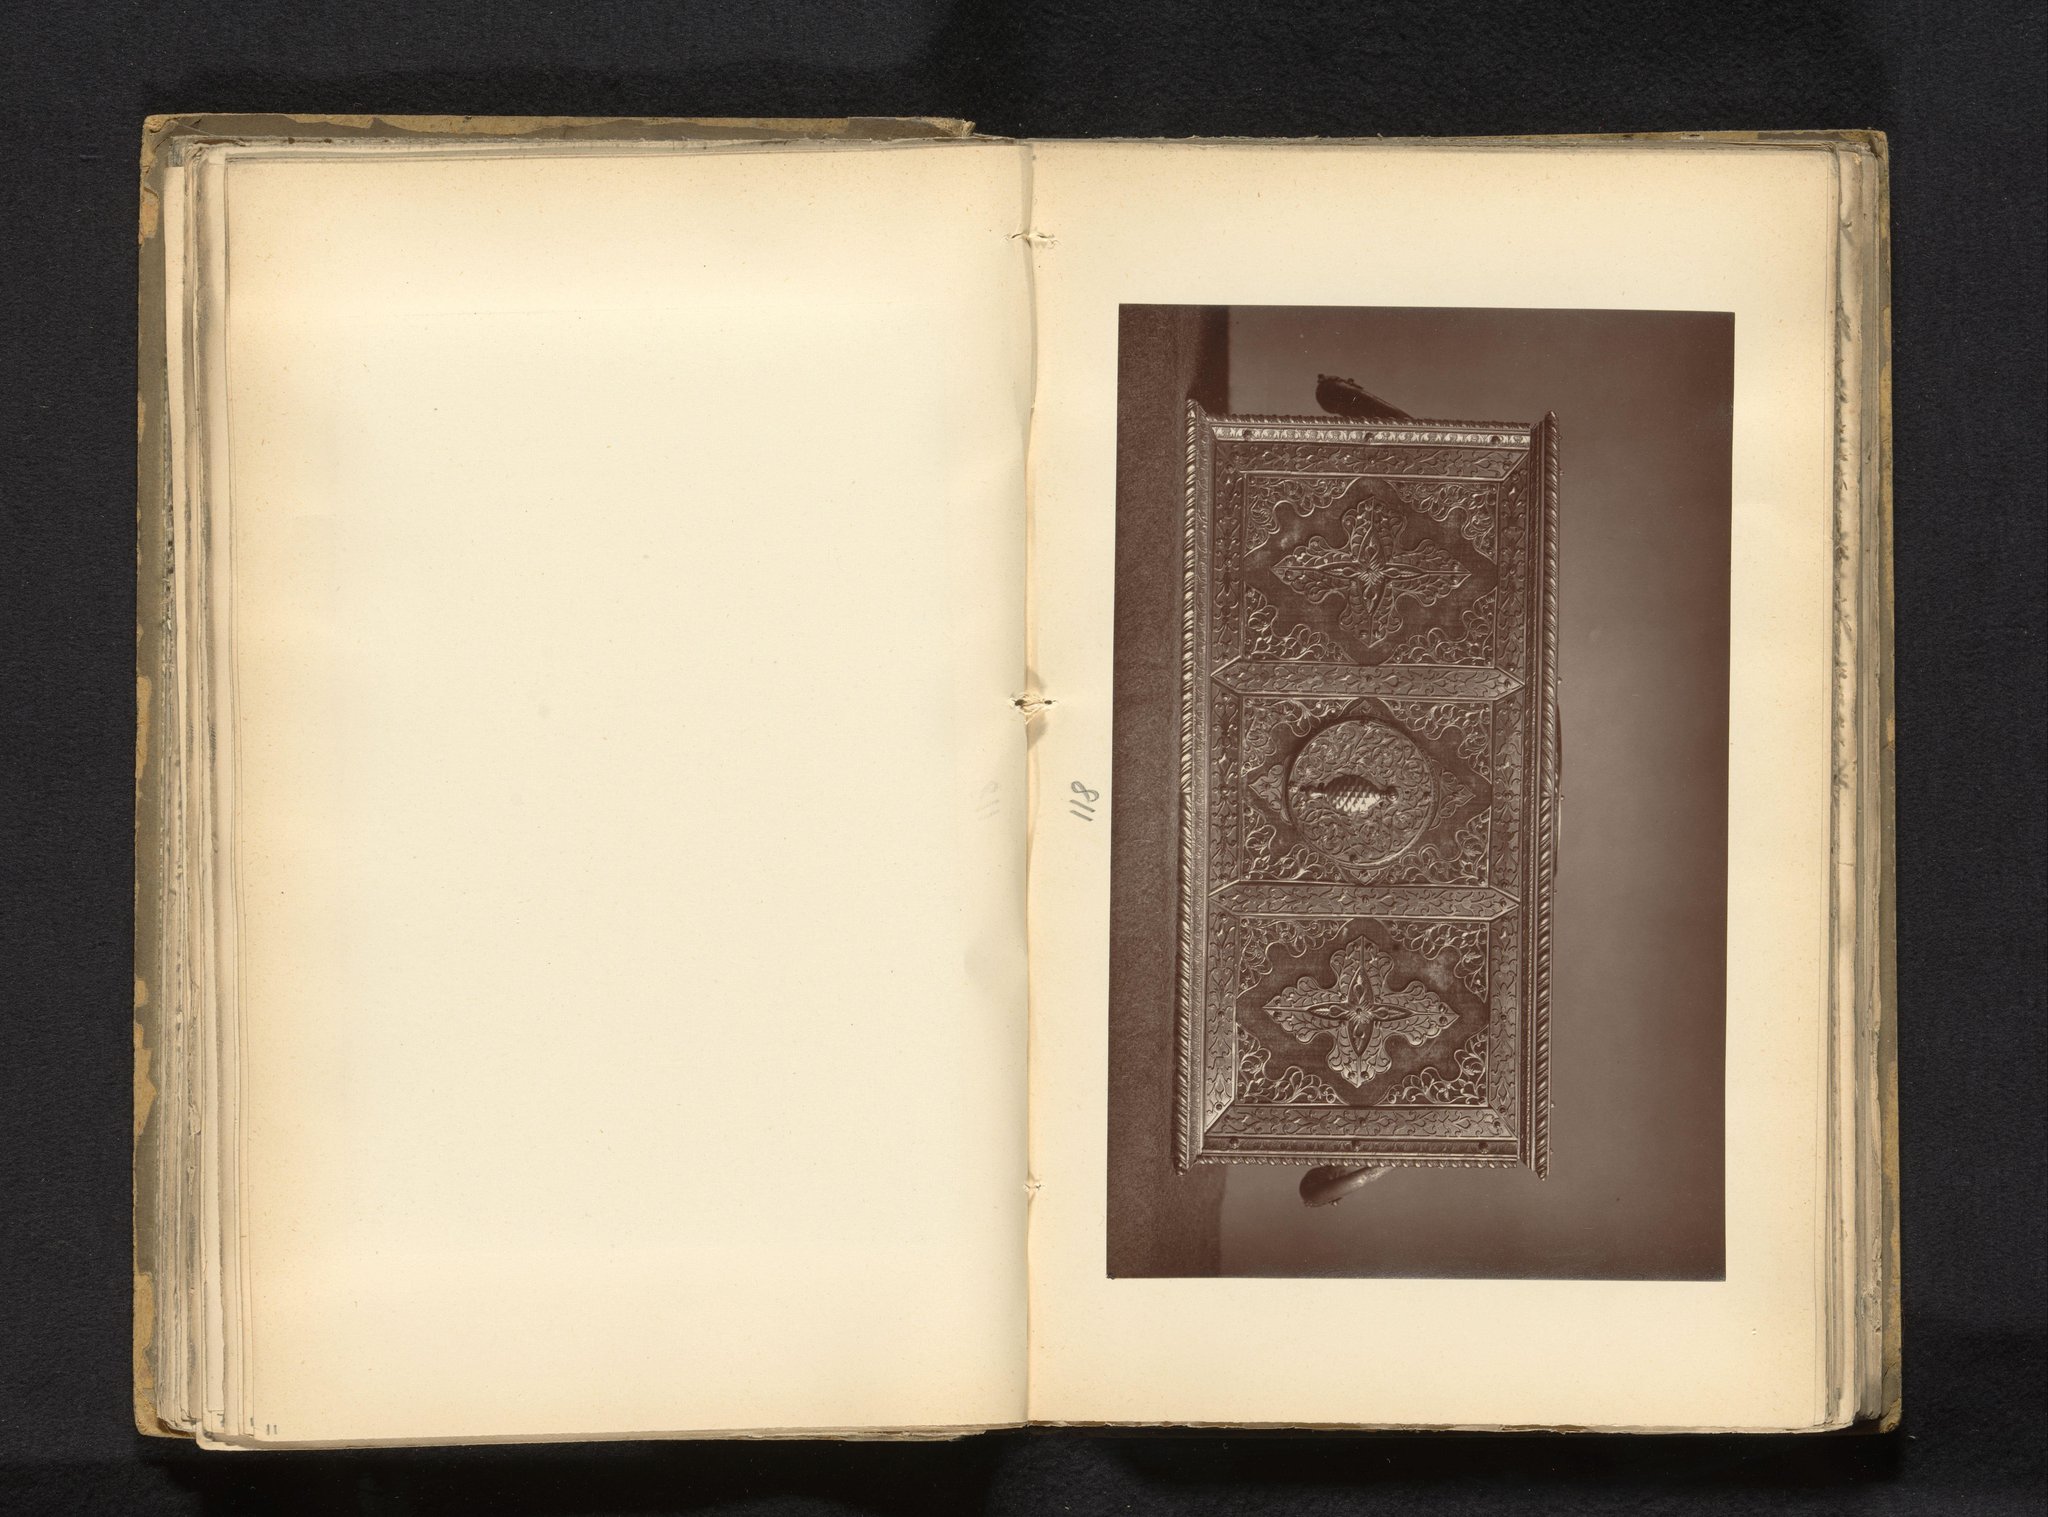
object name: page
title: Koffer gedecoreerd met metaal, uit de collectie van Christopher Beckett Denison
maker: Anonymous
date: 1880-1885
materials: paper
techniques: woodburytype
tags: chest, coffer (+ wood and other phytogenic material)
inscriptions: number: ‘811’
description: Prent op negende ongenummerde pagina na pagina 78.